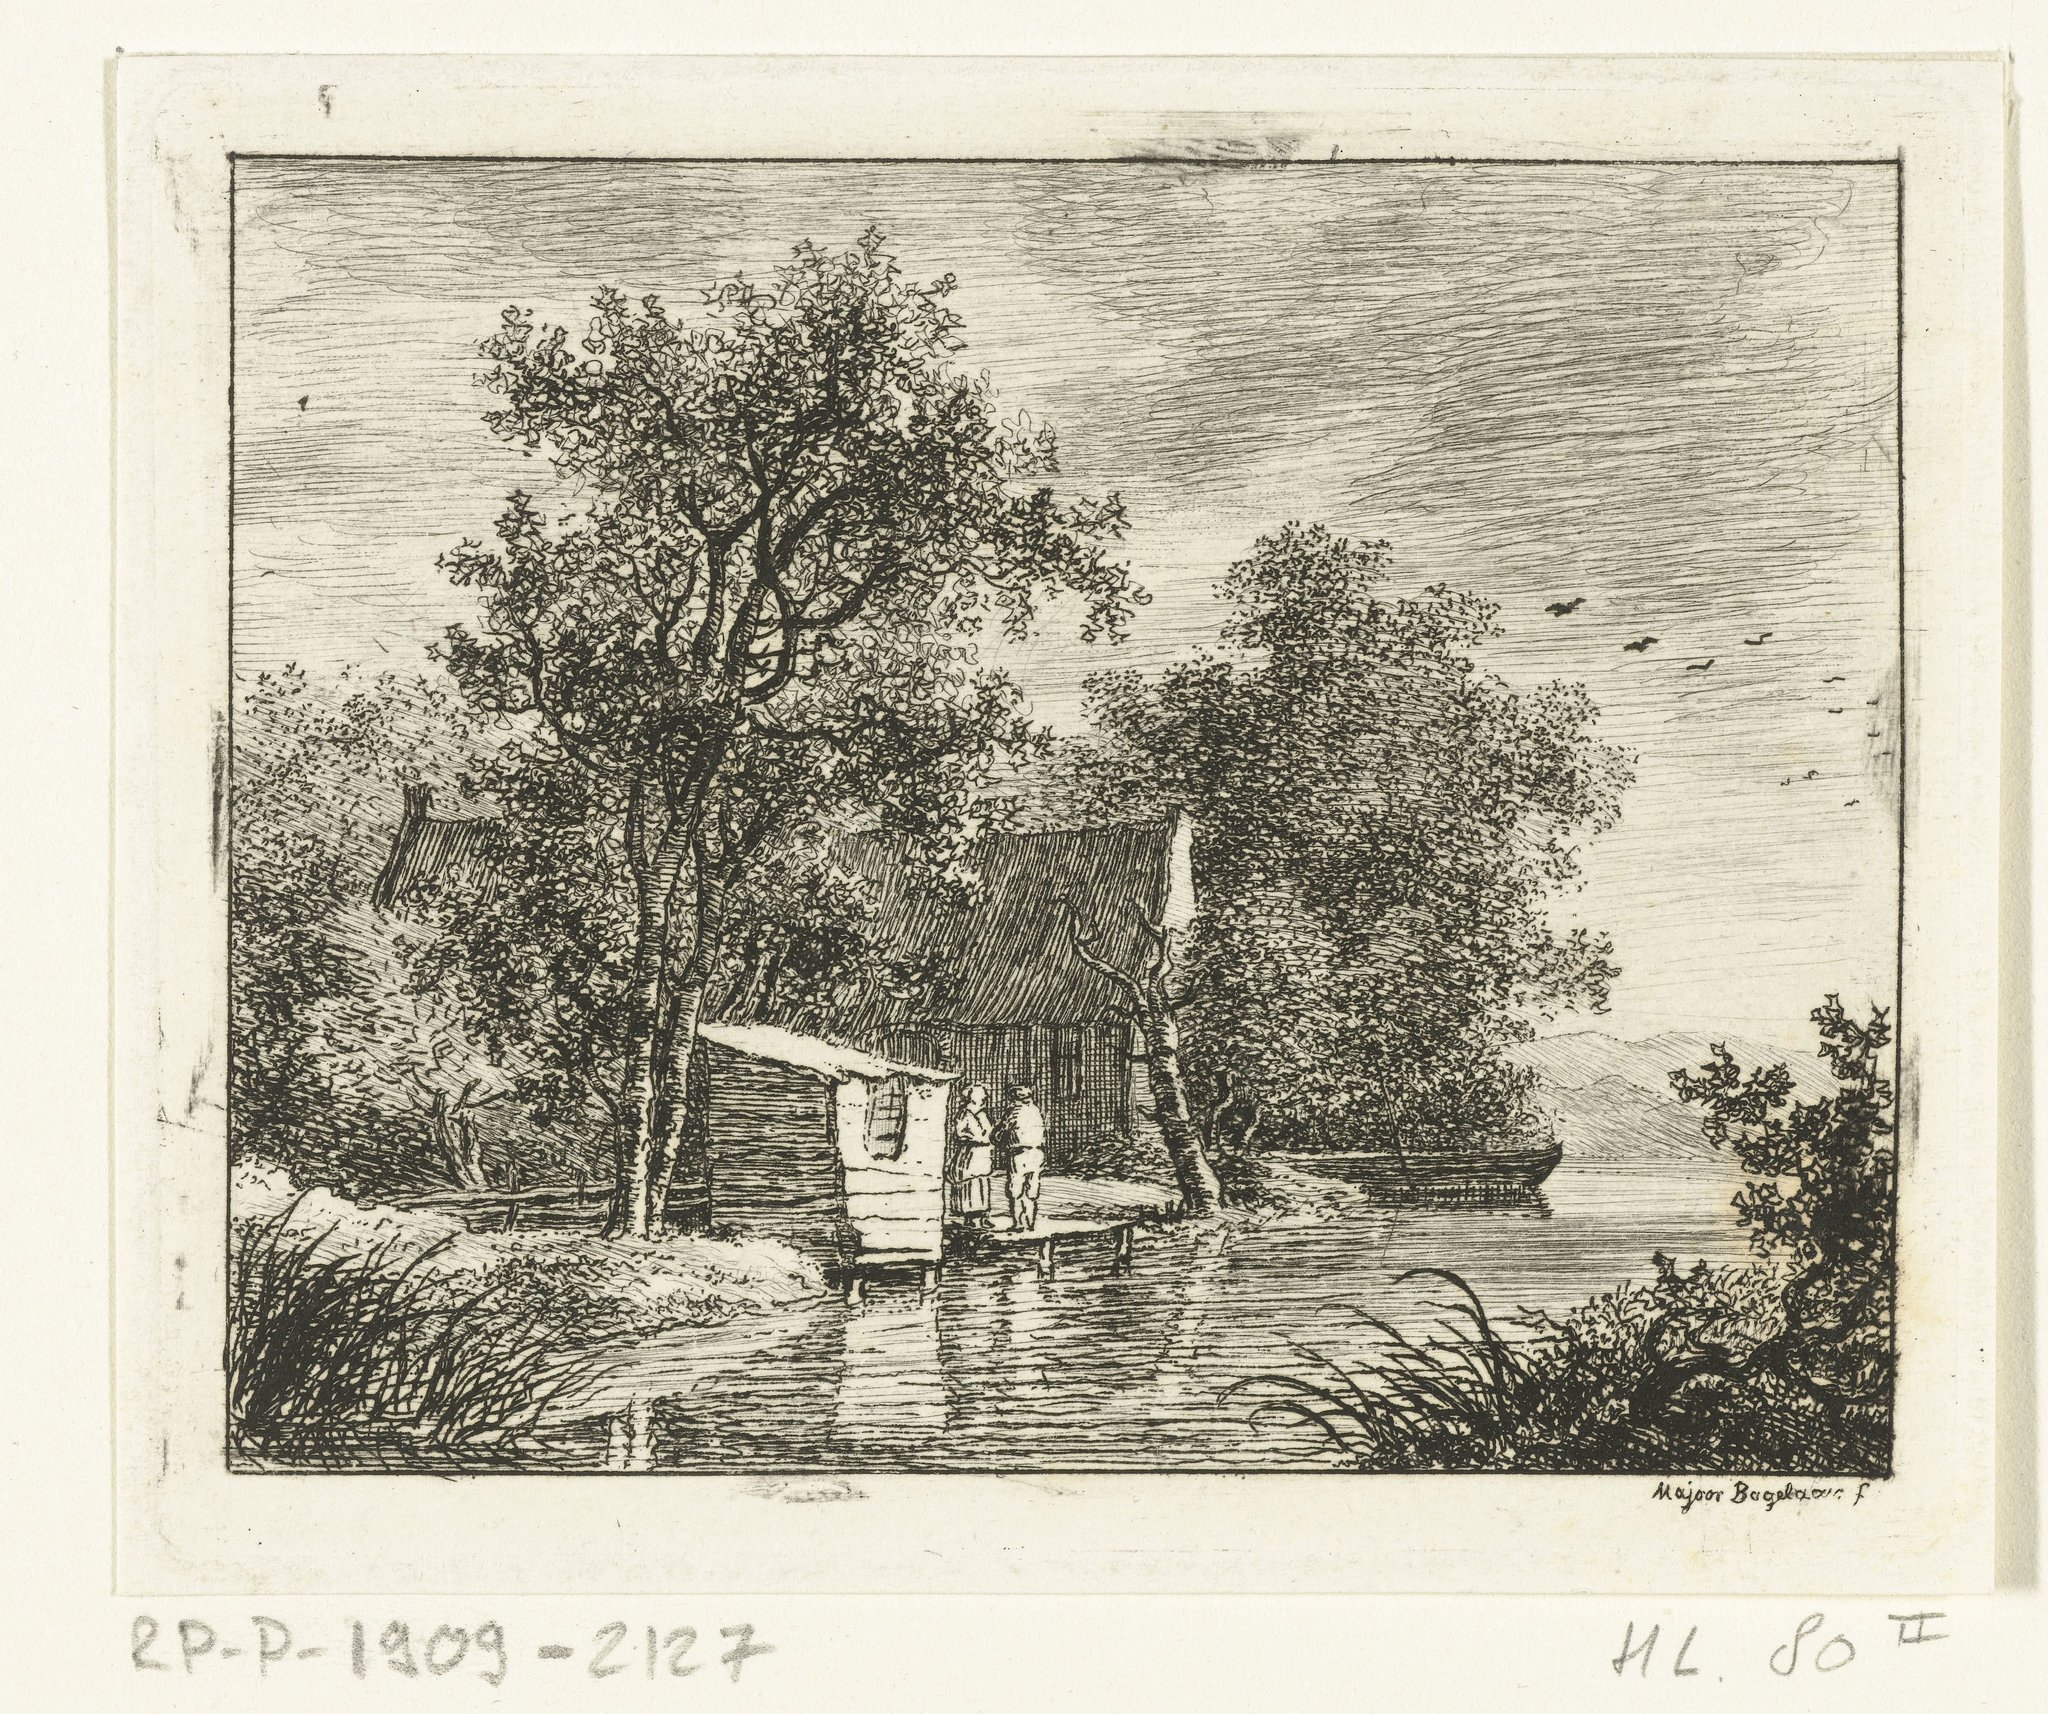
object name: print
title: Twee mannen bij een boothuis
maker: ernst willem jan bagelaar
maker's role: draughtsman, print maker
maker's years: 1775-1837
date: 1798-1837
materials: paper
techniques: drypoint, etching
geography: netherlands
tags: landscapes with waters, waterscapes, seascapes (in the temperate zone) (+ landscape with figures, staffage)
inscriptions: collector's mark: Lugt 2228